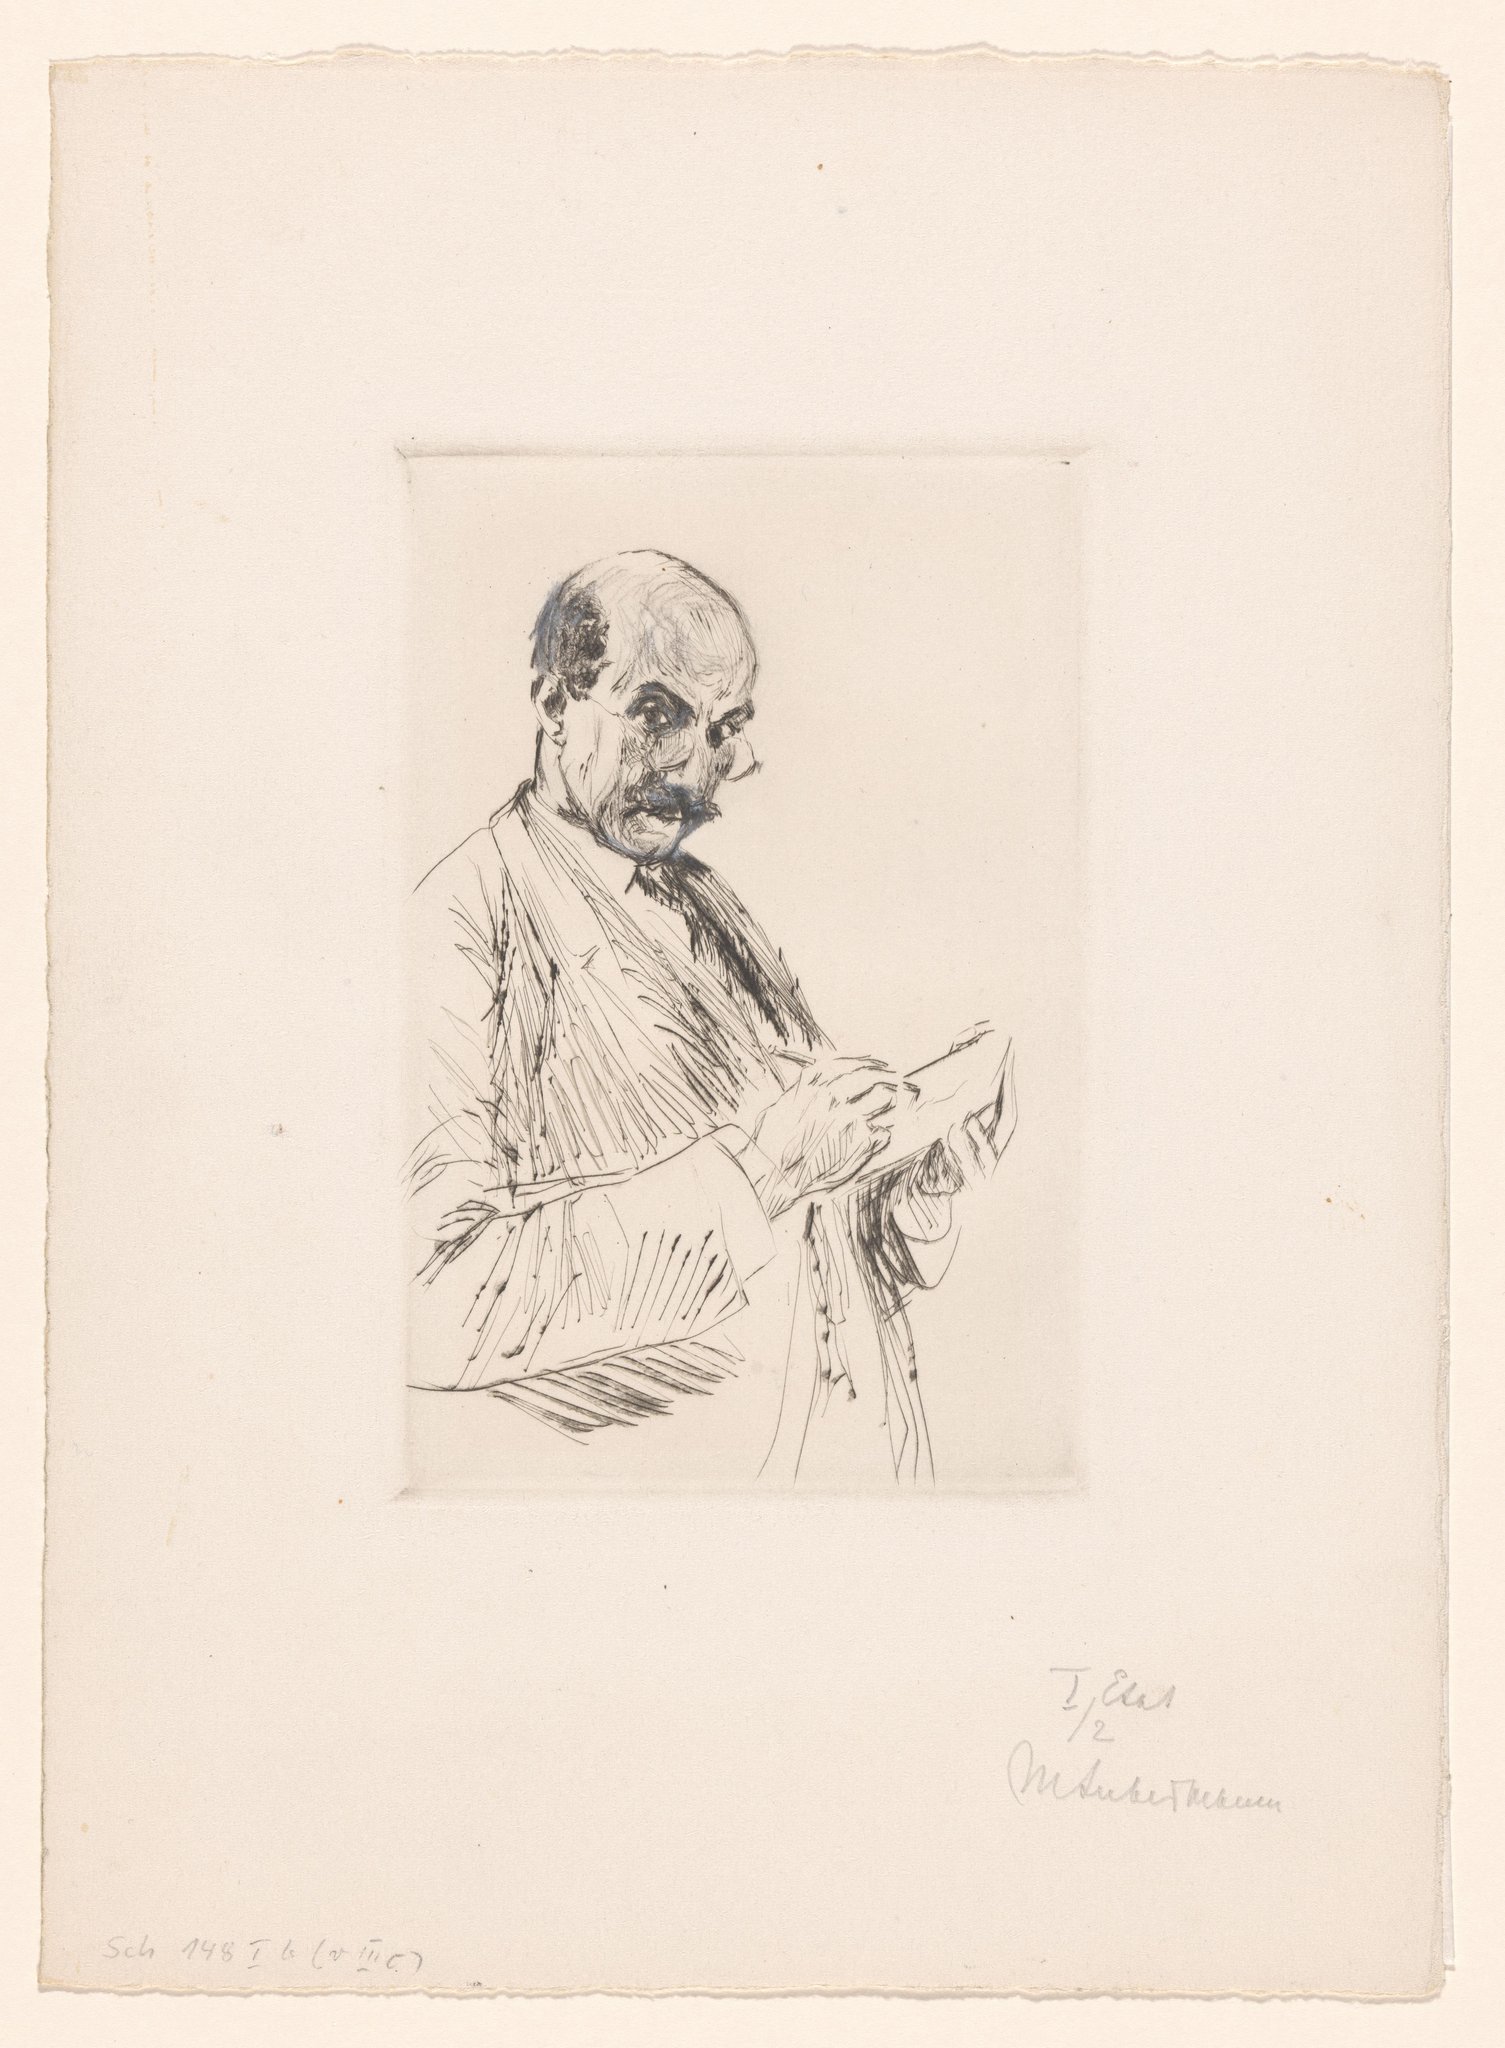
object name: print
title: Zelfportret van Max Liebermann, staand en tekenend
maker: max liebermann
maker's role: draughtsman, print maker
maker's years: 1847-1935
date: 1913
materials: chalk, charcoal, paper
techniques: drypoint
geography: germany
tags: berlin, print maker, draughtsman, max liebermann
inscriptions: signature: ‘MLiebermann’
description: Illustratie in: Missale Romanum, Antwerpen: Christopher Plantin 1585. In deze publicatie bevinden zich 48 illustraties van verschillende afmetingen, sommige afbeeldingen zelfs twee maal, naar ontwerpen van Peeter van der Borcht en Crispijn van den Broeck. Deze prent bevindt zich op p. 394.